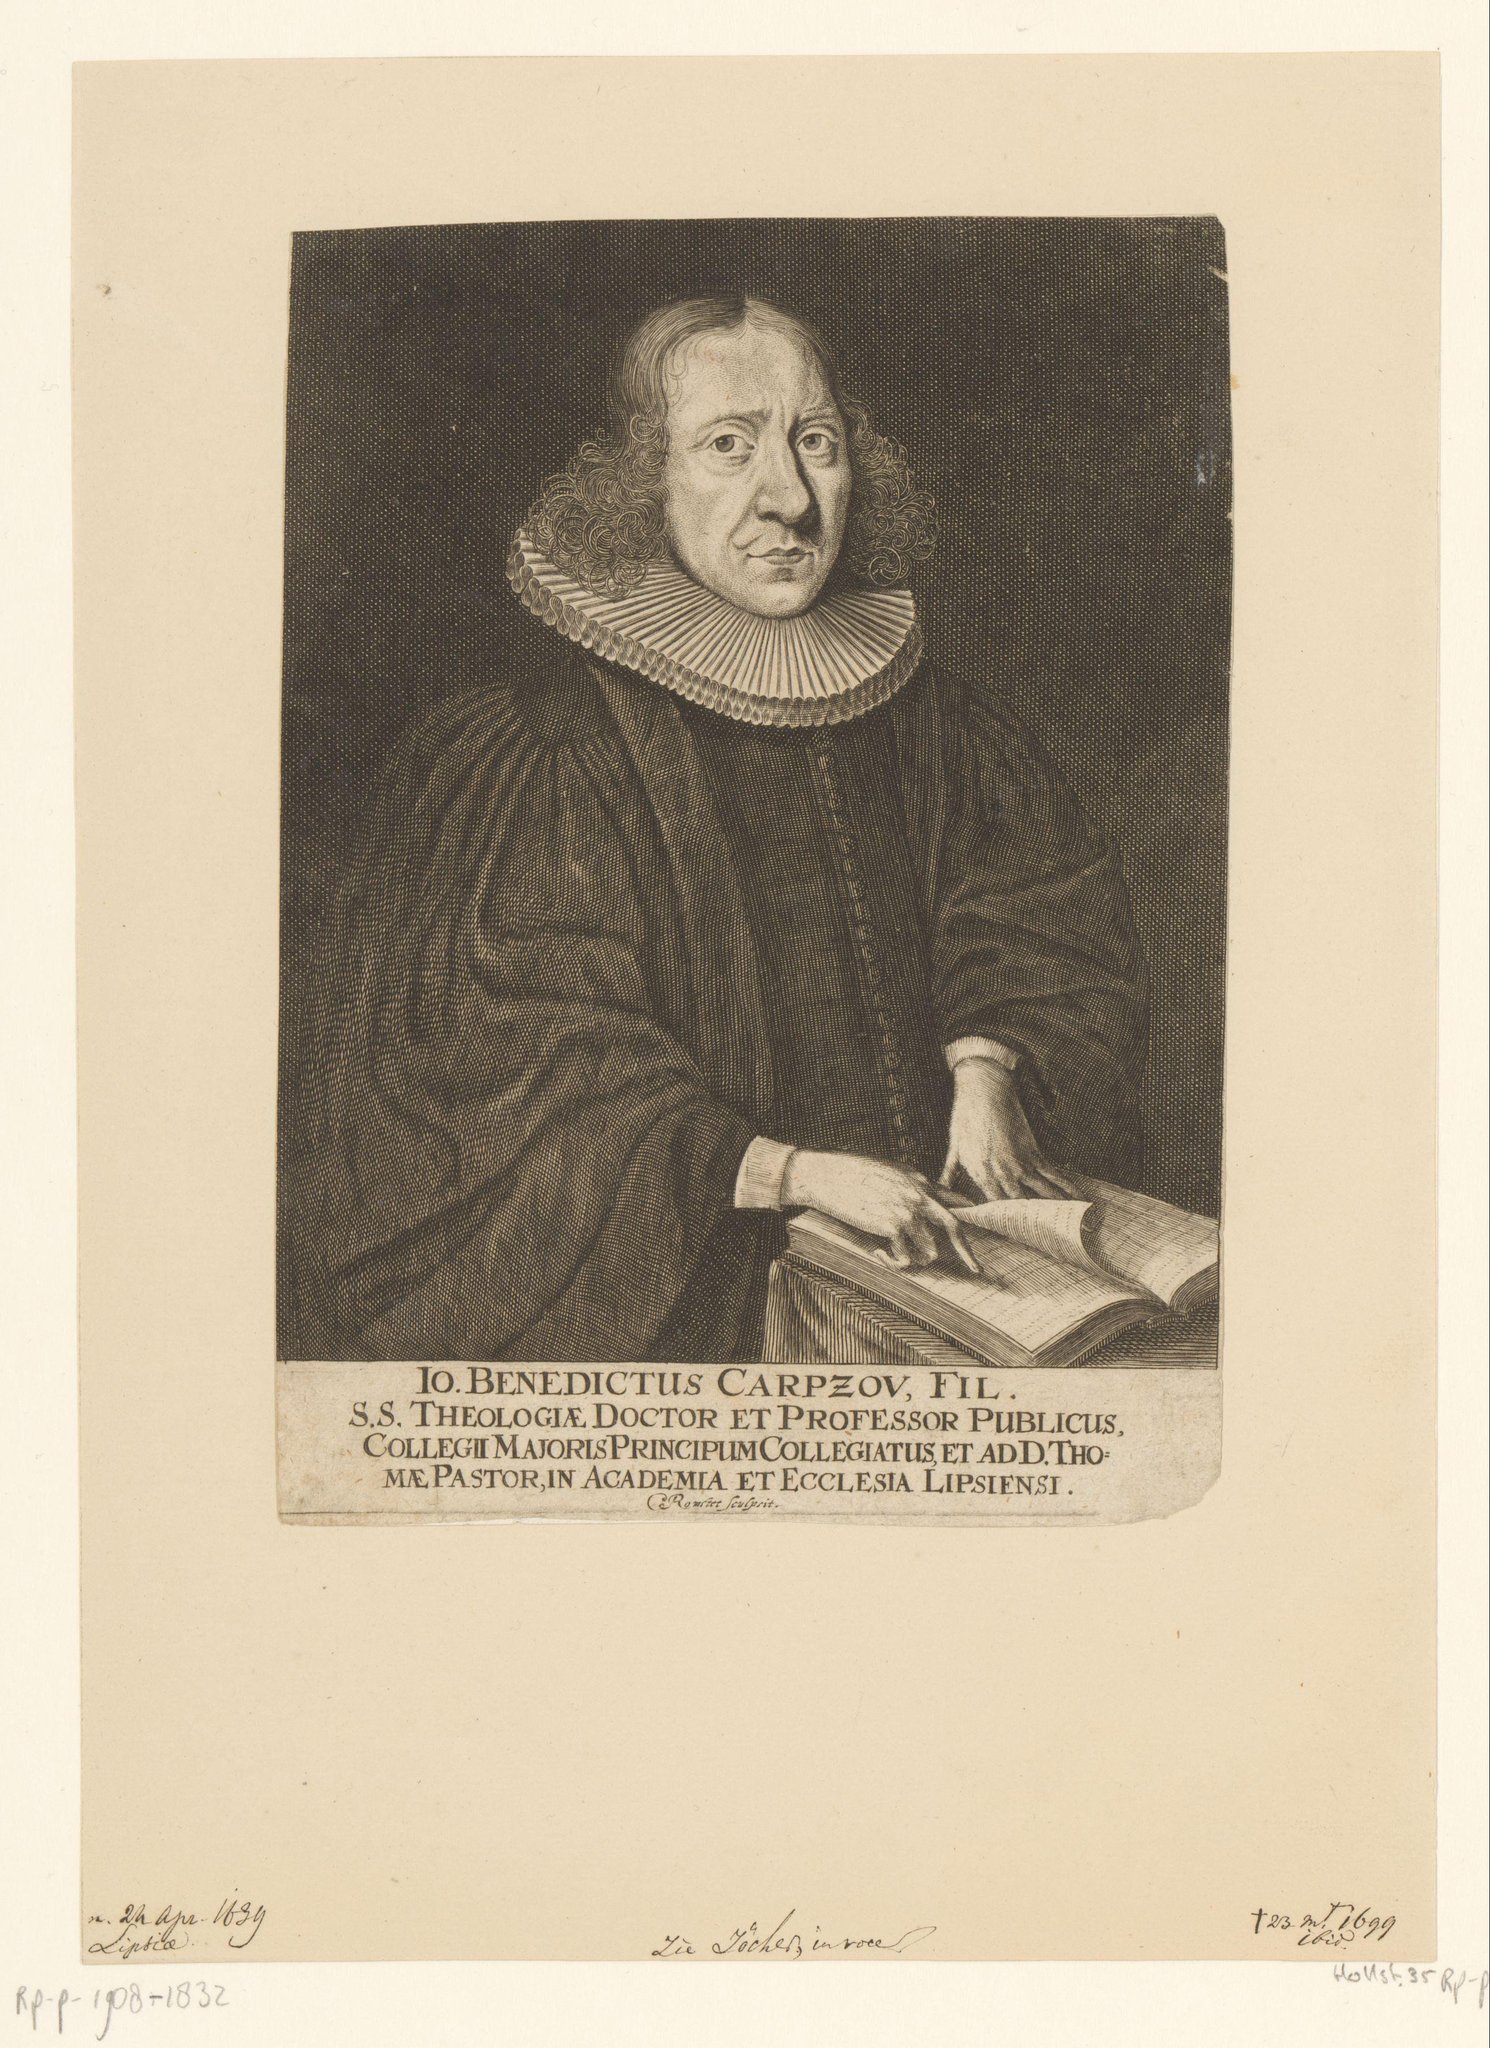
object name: print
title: Portret van Johann Benedikt Carpzov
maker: christian romstet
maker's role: print maker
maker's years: 1640-1721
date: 1665-1721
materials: paper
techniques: engraving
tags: theologian, historical persons, book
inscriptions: collector's mark: Lugt 2228